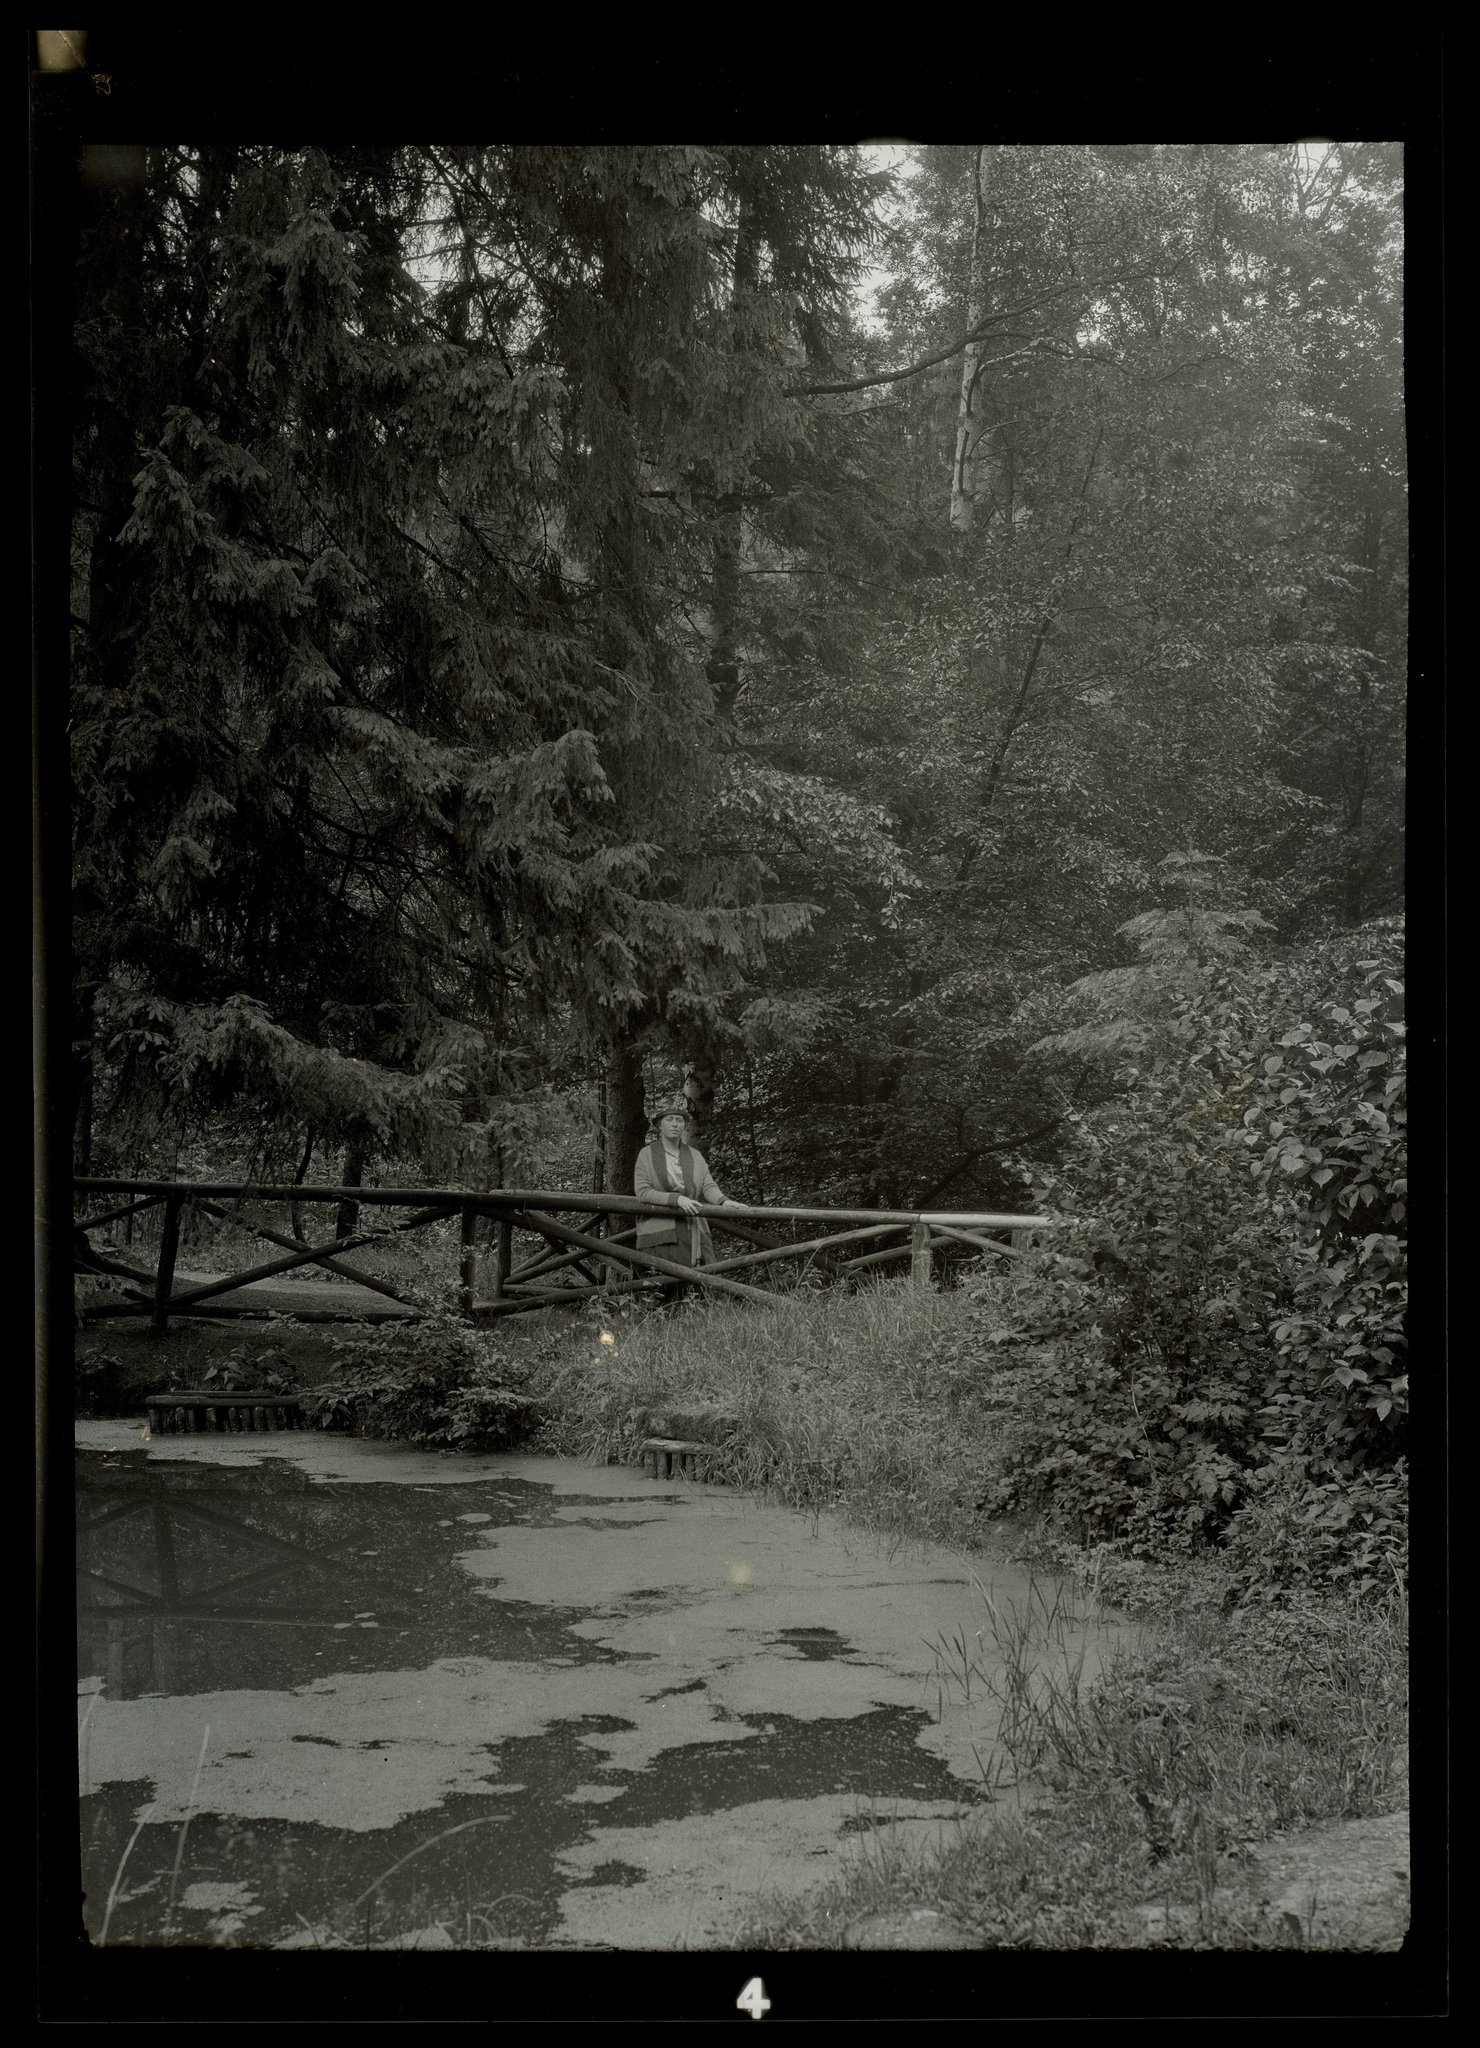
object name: negative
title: Filmnegatief met opname van Eisenach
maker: Anonymous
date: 1921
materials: film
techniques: gelatin silver negative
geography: germany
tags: eisenach